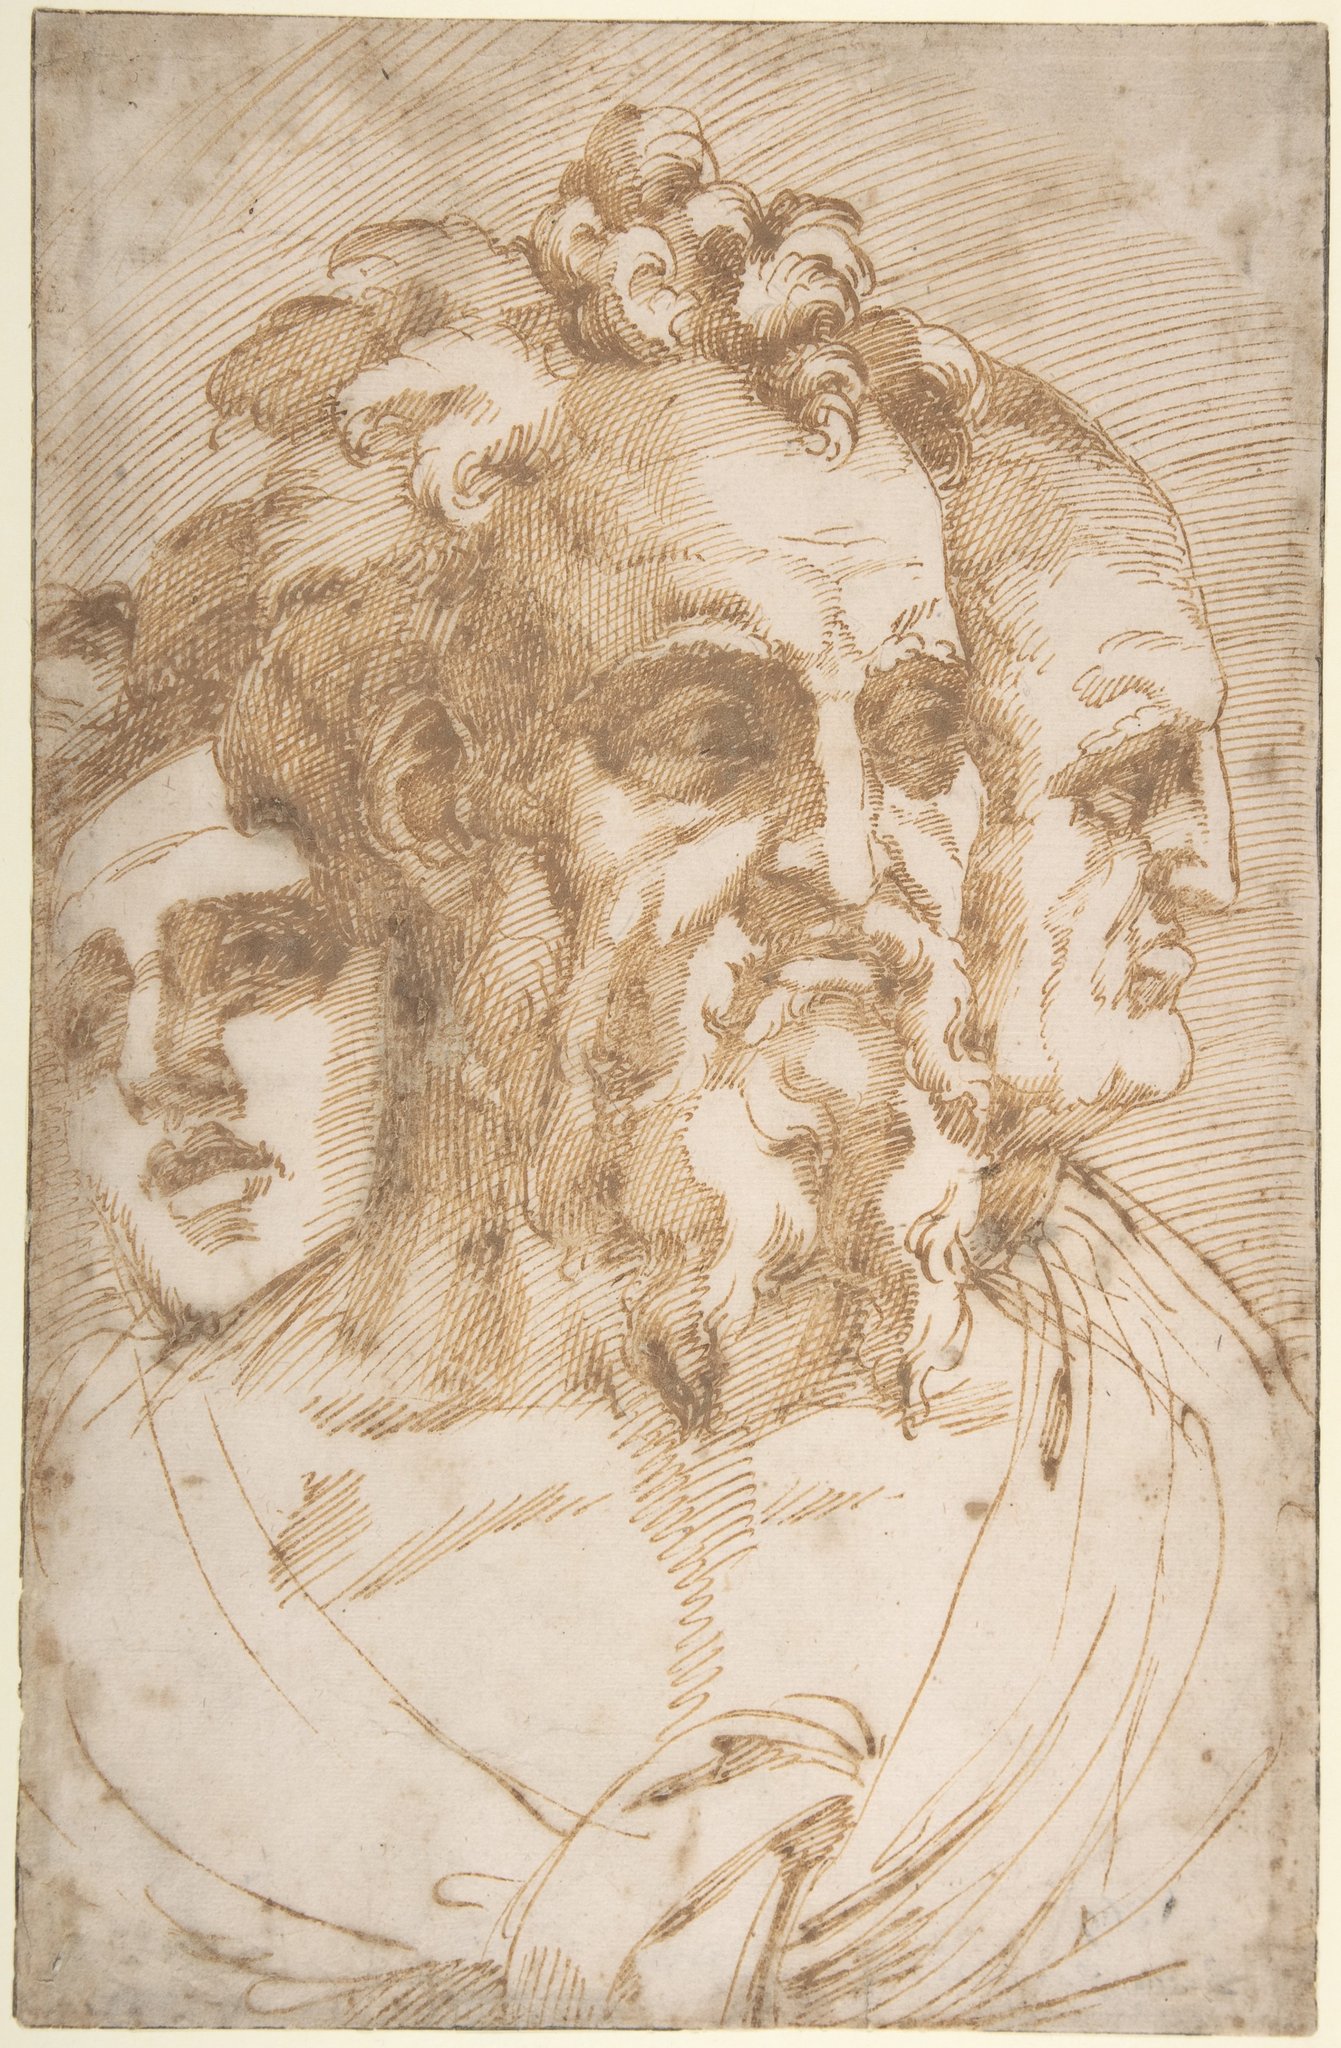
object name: drawing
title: Three Male Heads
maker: baccio bandinelli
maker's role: artist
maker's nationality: italian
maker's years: 1493-1560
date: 1493-1560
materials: chalk, ink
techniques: pen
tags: heads,men